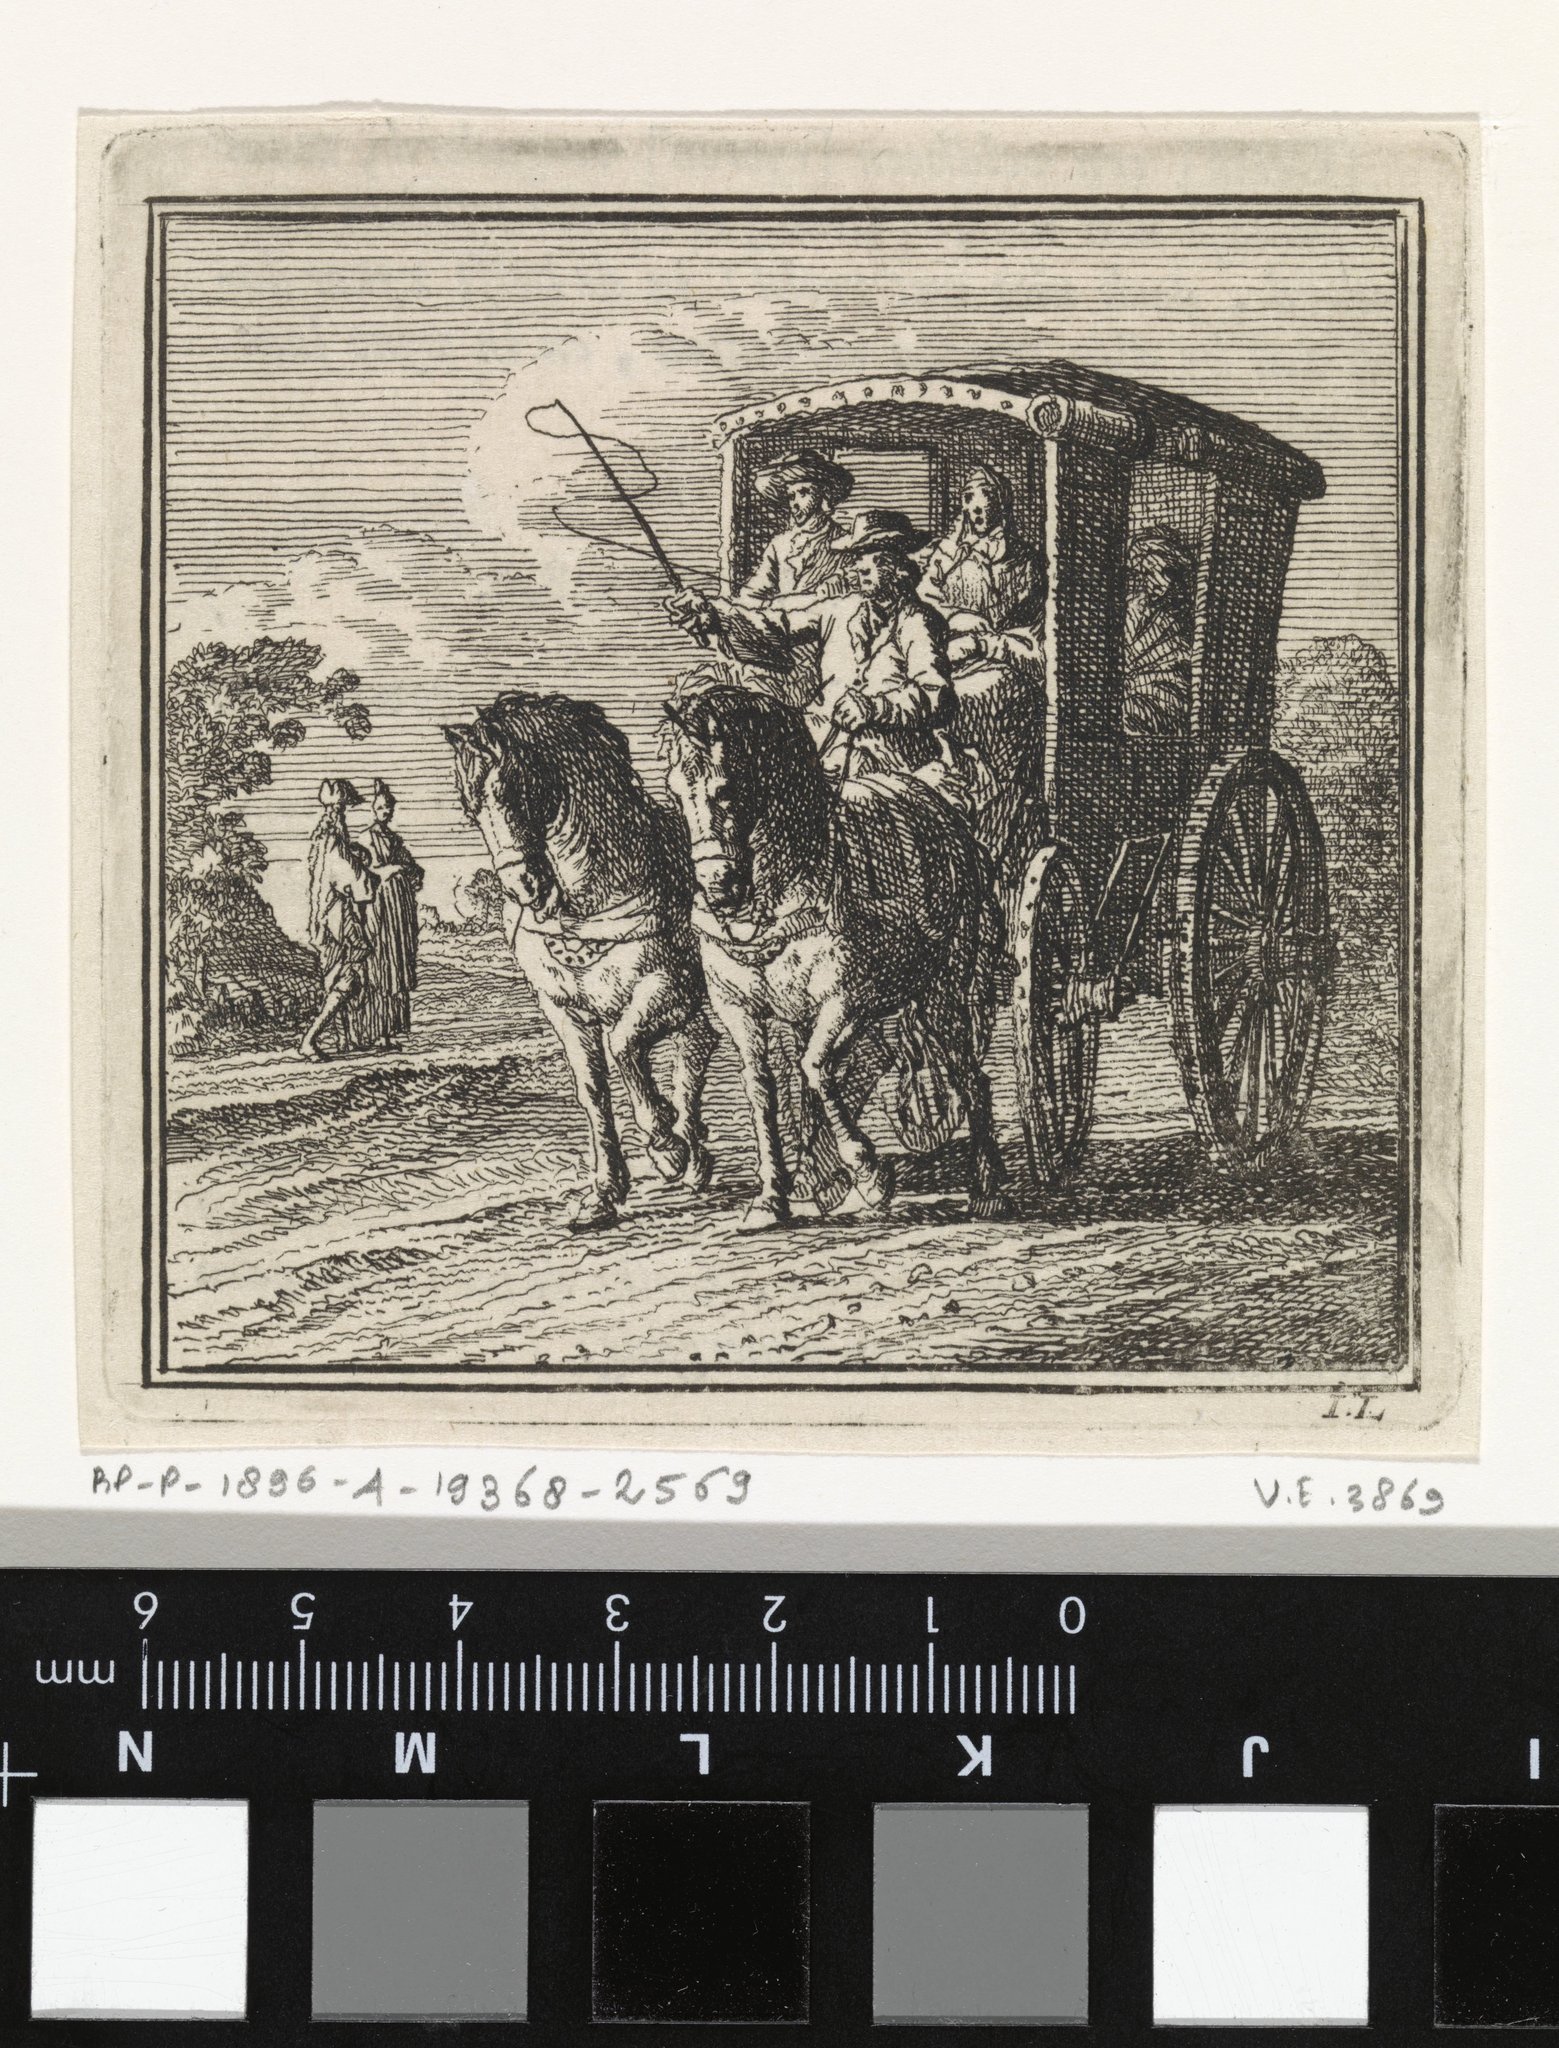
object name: book illustration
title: Vier figuren in een koets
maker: jan luyken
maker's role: draughtsman, print maker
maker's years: 1649-1712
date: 1711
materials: paper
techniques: etching, letterpress printing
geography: amsterdam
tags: four-wheeled vehicle drawn by two animals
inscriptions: collector's mark: Lugt 2228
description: Illustratie voor: Luyken, Jan. De Bykorf des Gemoeds. Amsterdam: Pieter Arentsz. II (wed.) en Cornelis van der Sys, 1711, p. 82.